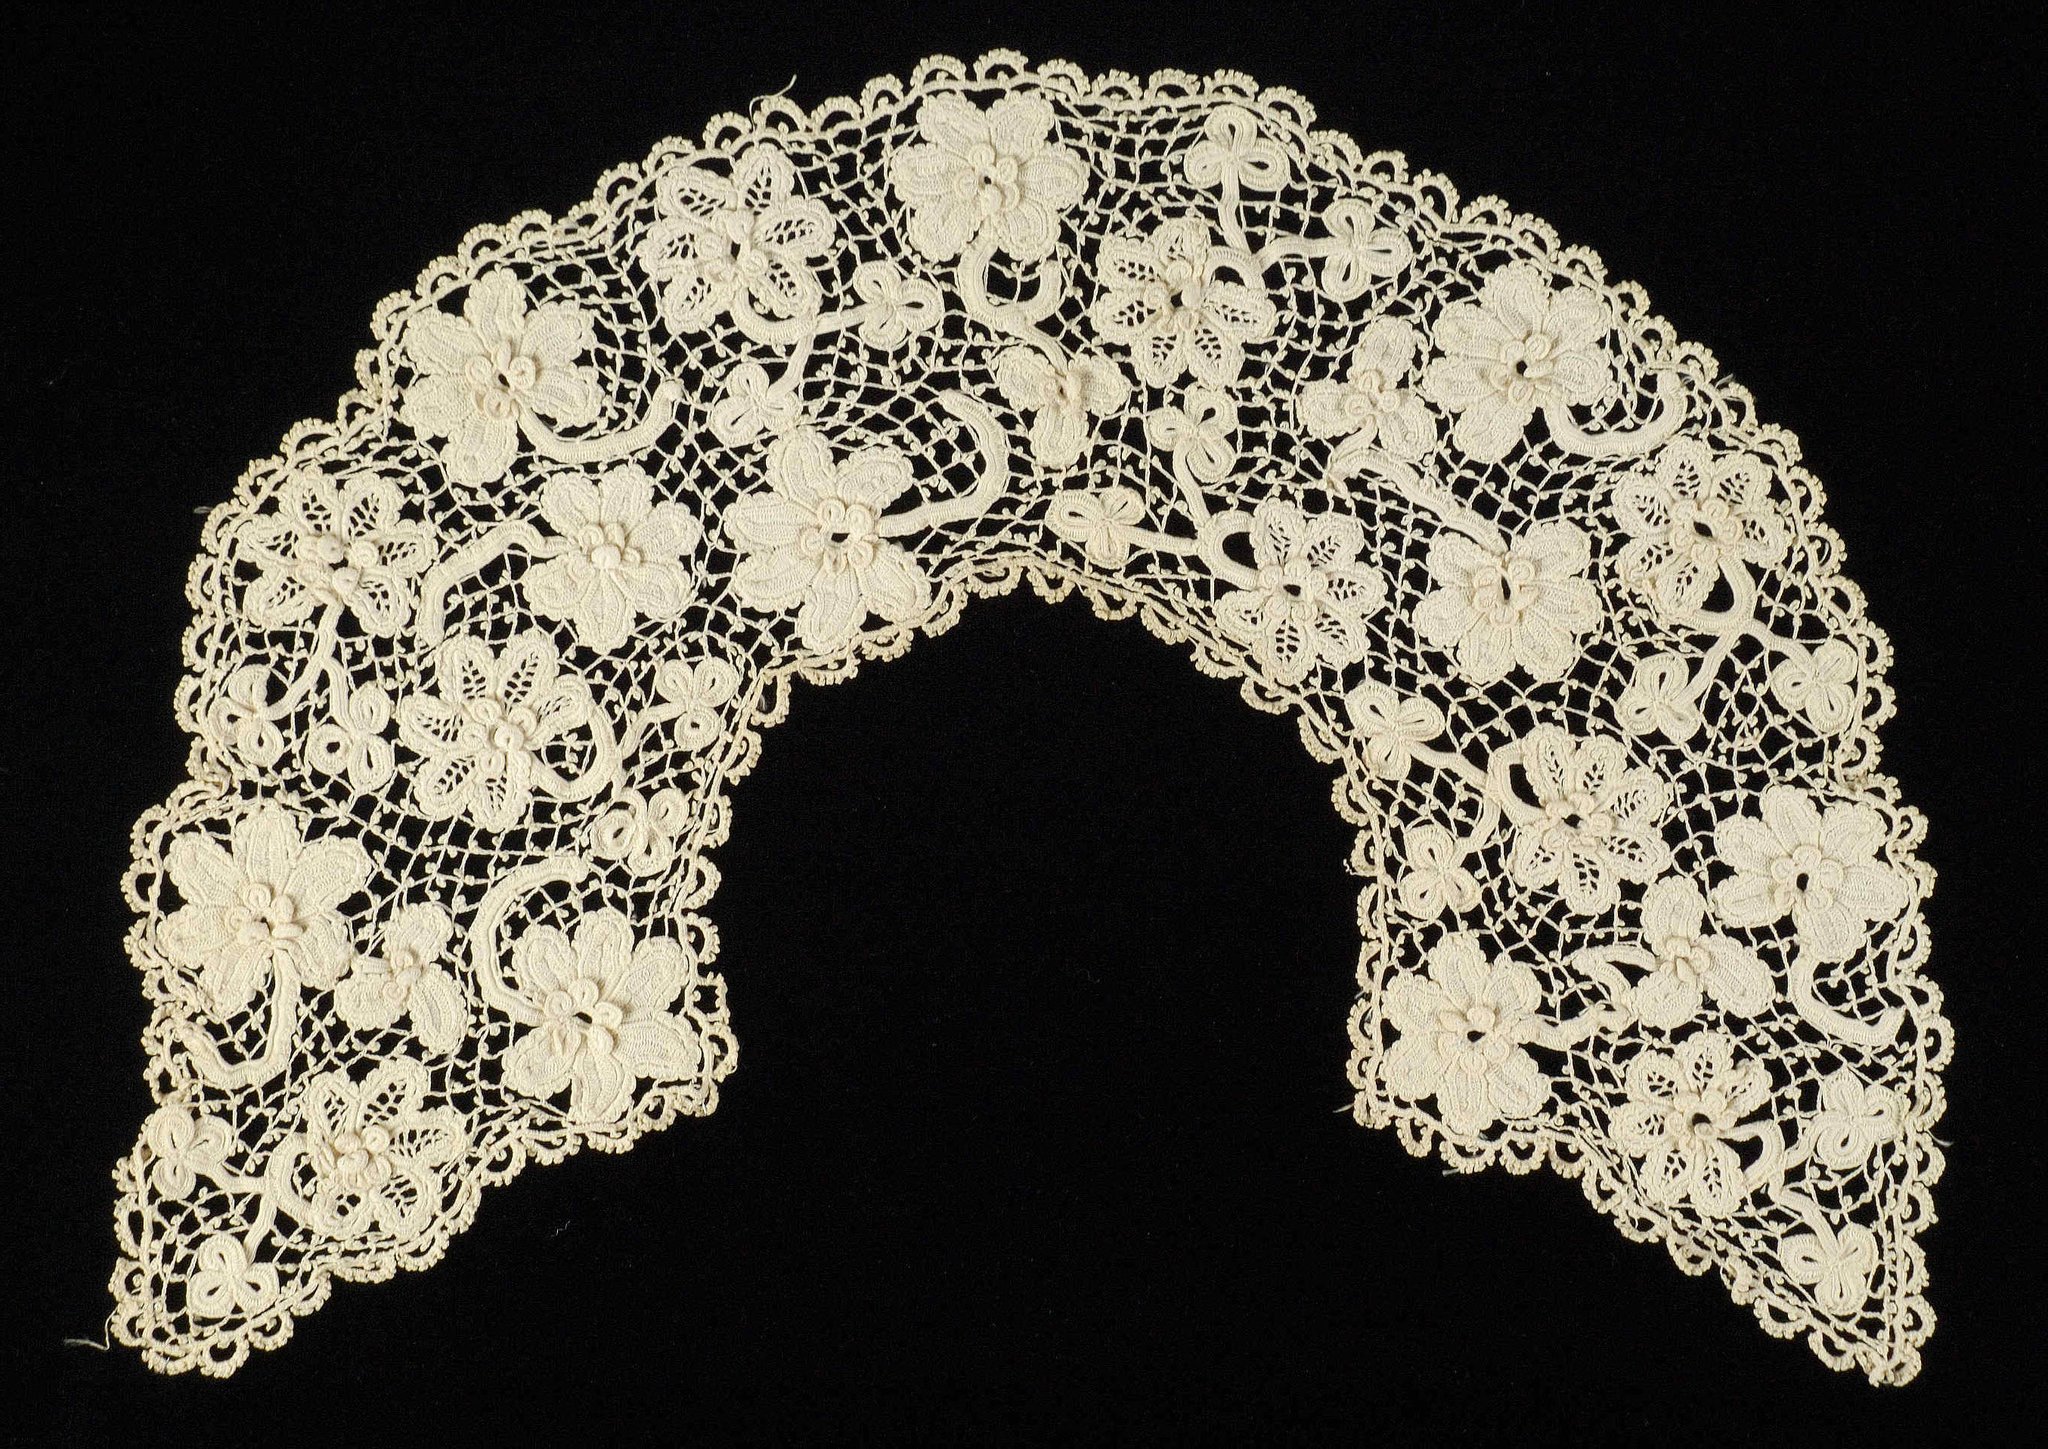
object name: collar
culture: irish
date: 1890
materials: cotton